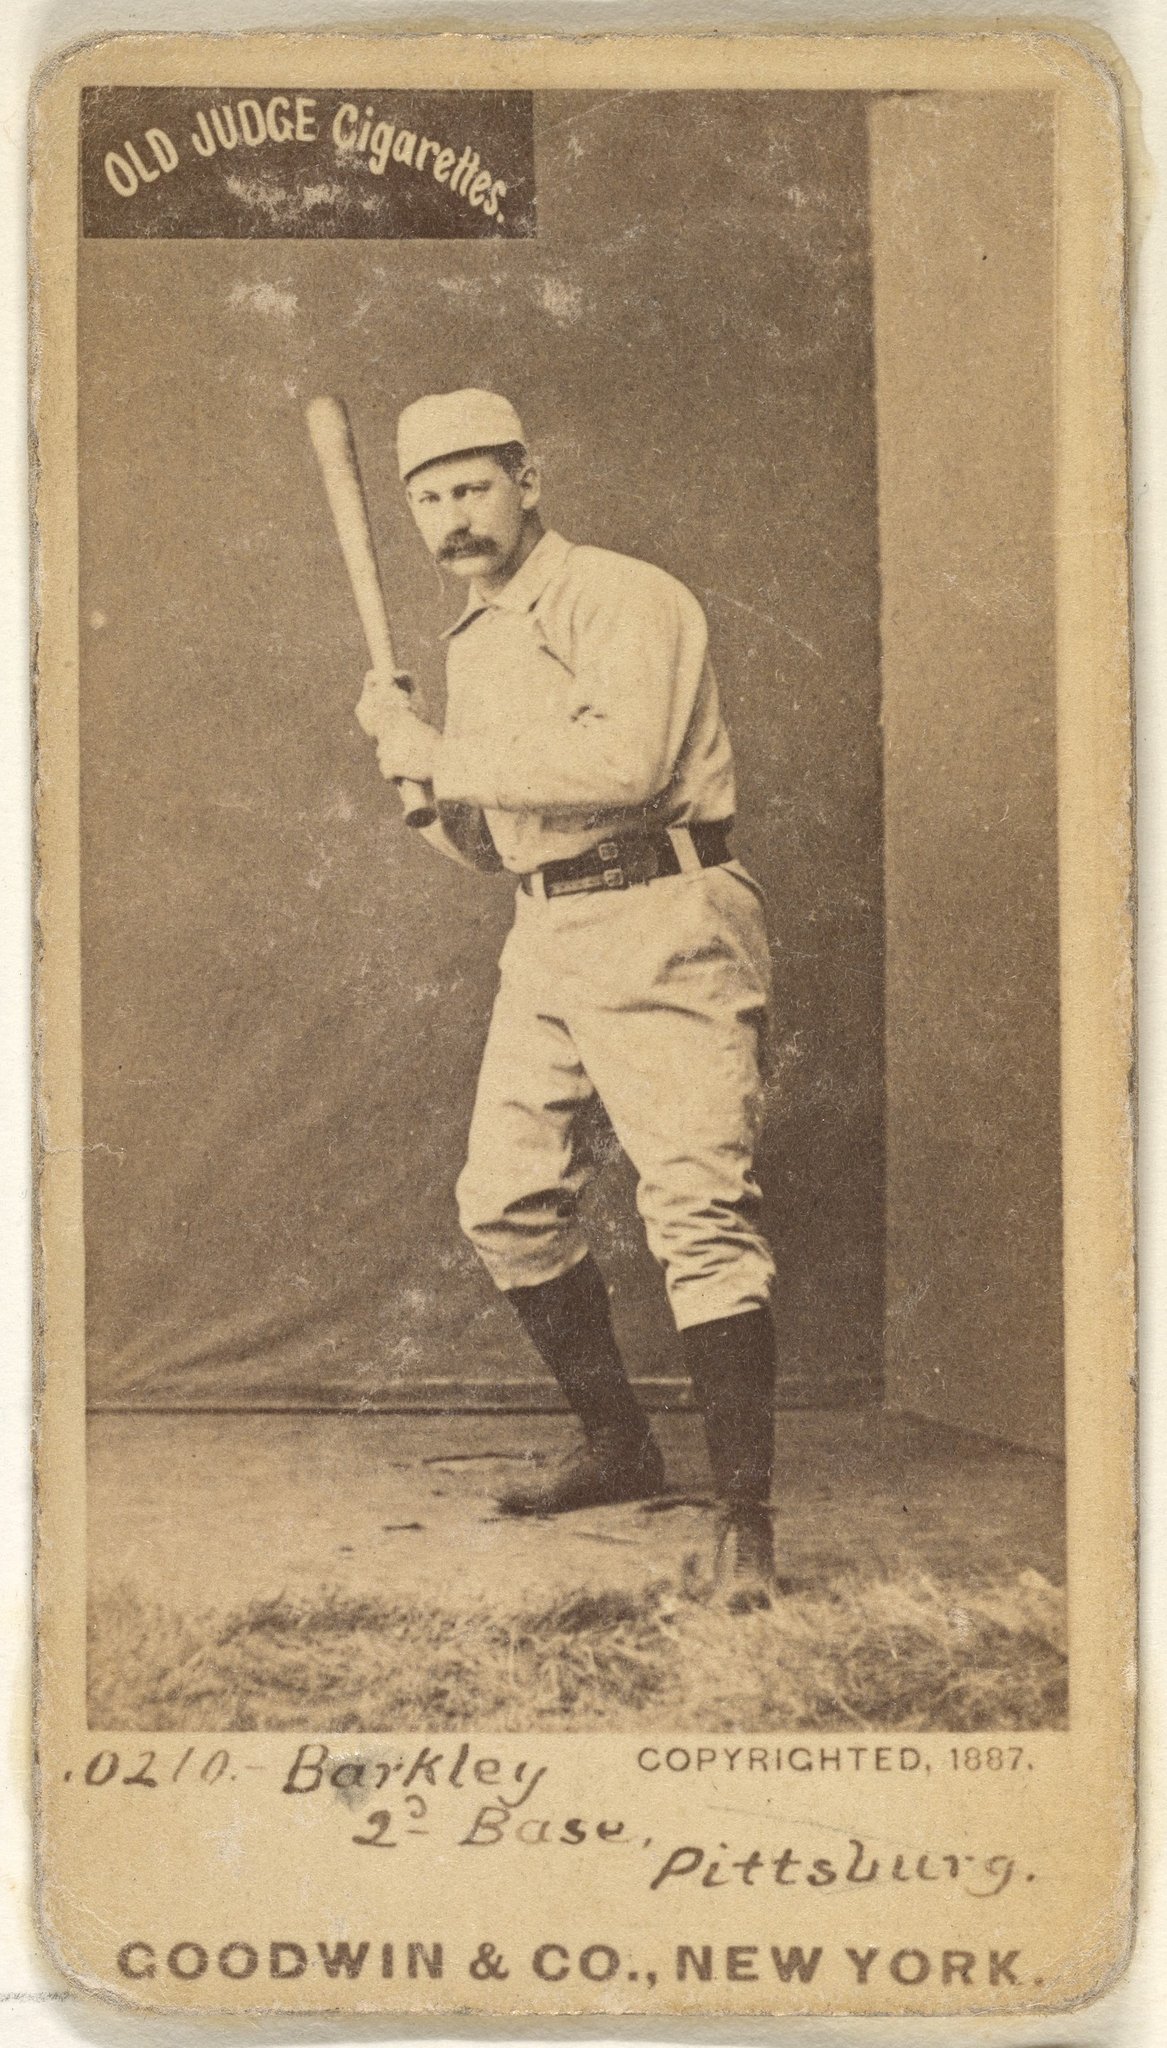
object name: baseball card, photograph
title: Sam Barkley, 2nd Base, Pittsburgh, from the Old Judge series (N172) for Old Judge Cigarettes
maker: goodwin & company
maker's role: publisher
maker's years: 1850-1950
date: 1887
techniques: albumen silver print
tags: men,portraits,baseball,athletes